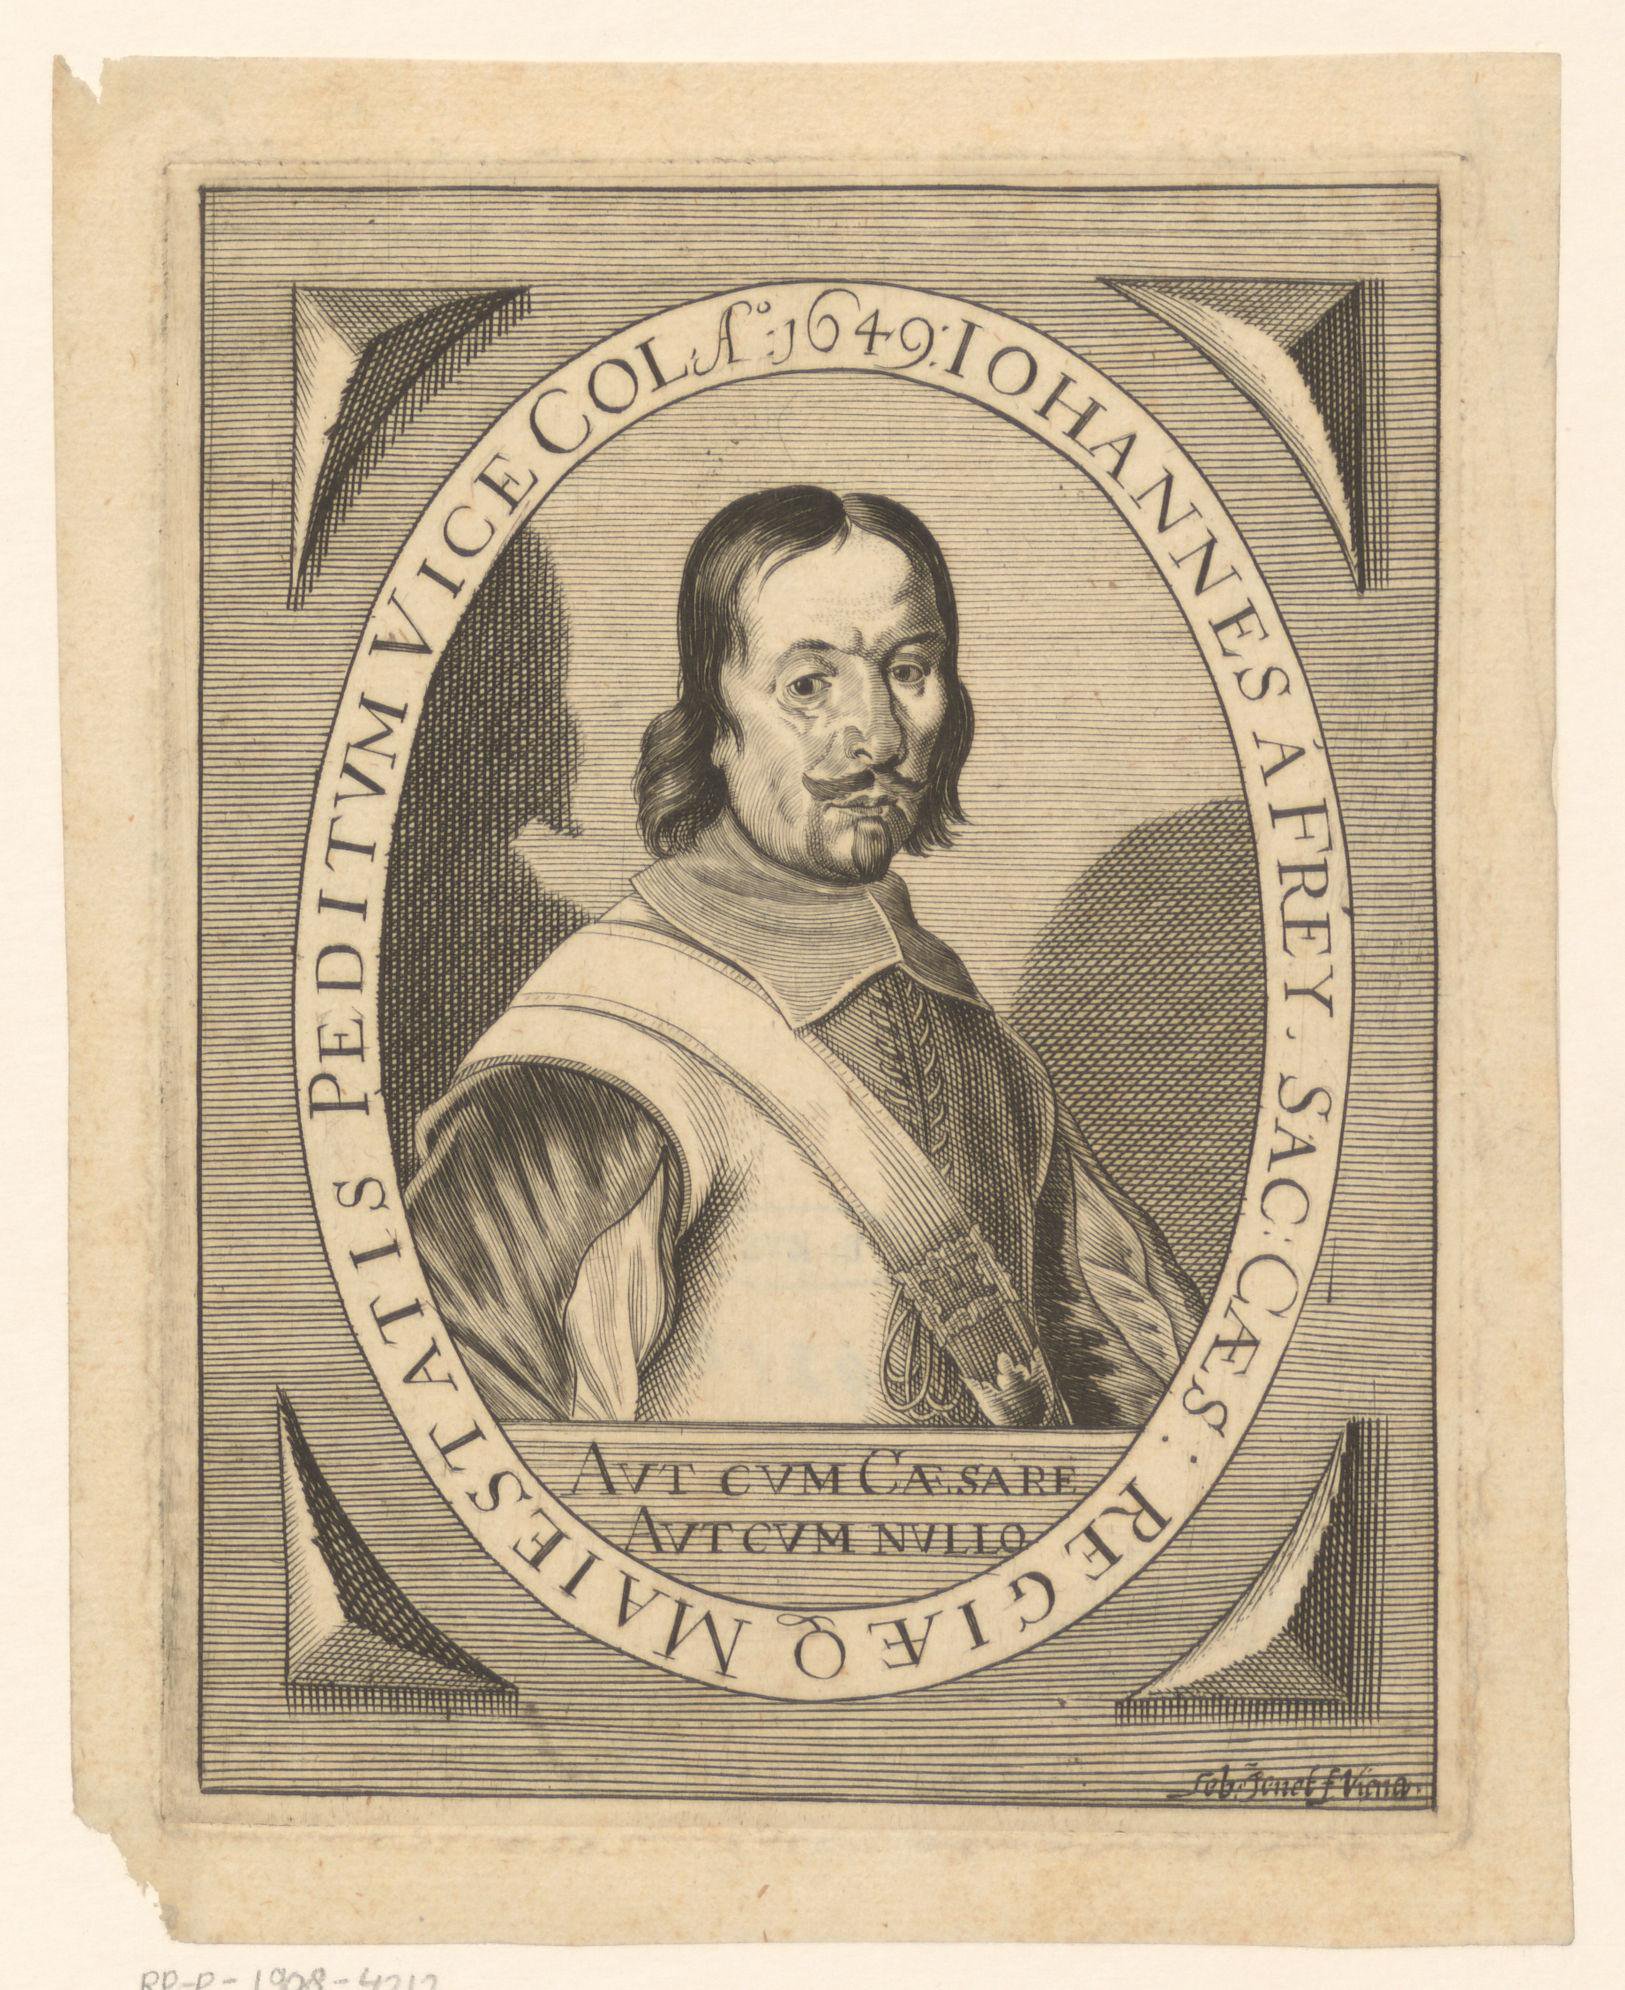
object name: print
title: Portret van Johann von Frey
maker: sebastian jenet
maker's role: draughtsman, print maker, publisher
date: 1649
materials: paper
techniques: engraving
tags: historical persons, officer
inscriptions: collector's mark: Lugt 2228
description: Deze prent maakt deel uit van een serie van achttien portretten voor: Widemann, Elias. Comitium Gloriae Centum Qua Sanguine Qua Virtute Illustrium Heroum Iconibus Instructum Et Excelmo. Ac Illustrissimo Heroi D.D. Joanni Christophoro Com: a Puchaim (...) Dicatum. Wenen: Matthaeus Cosmerovius, 1650.